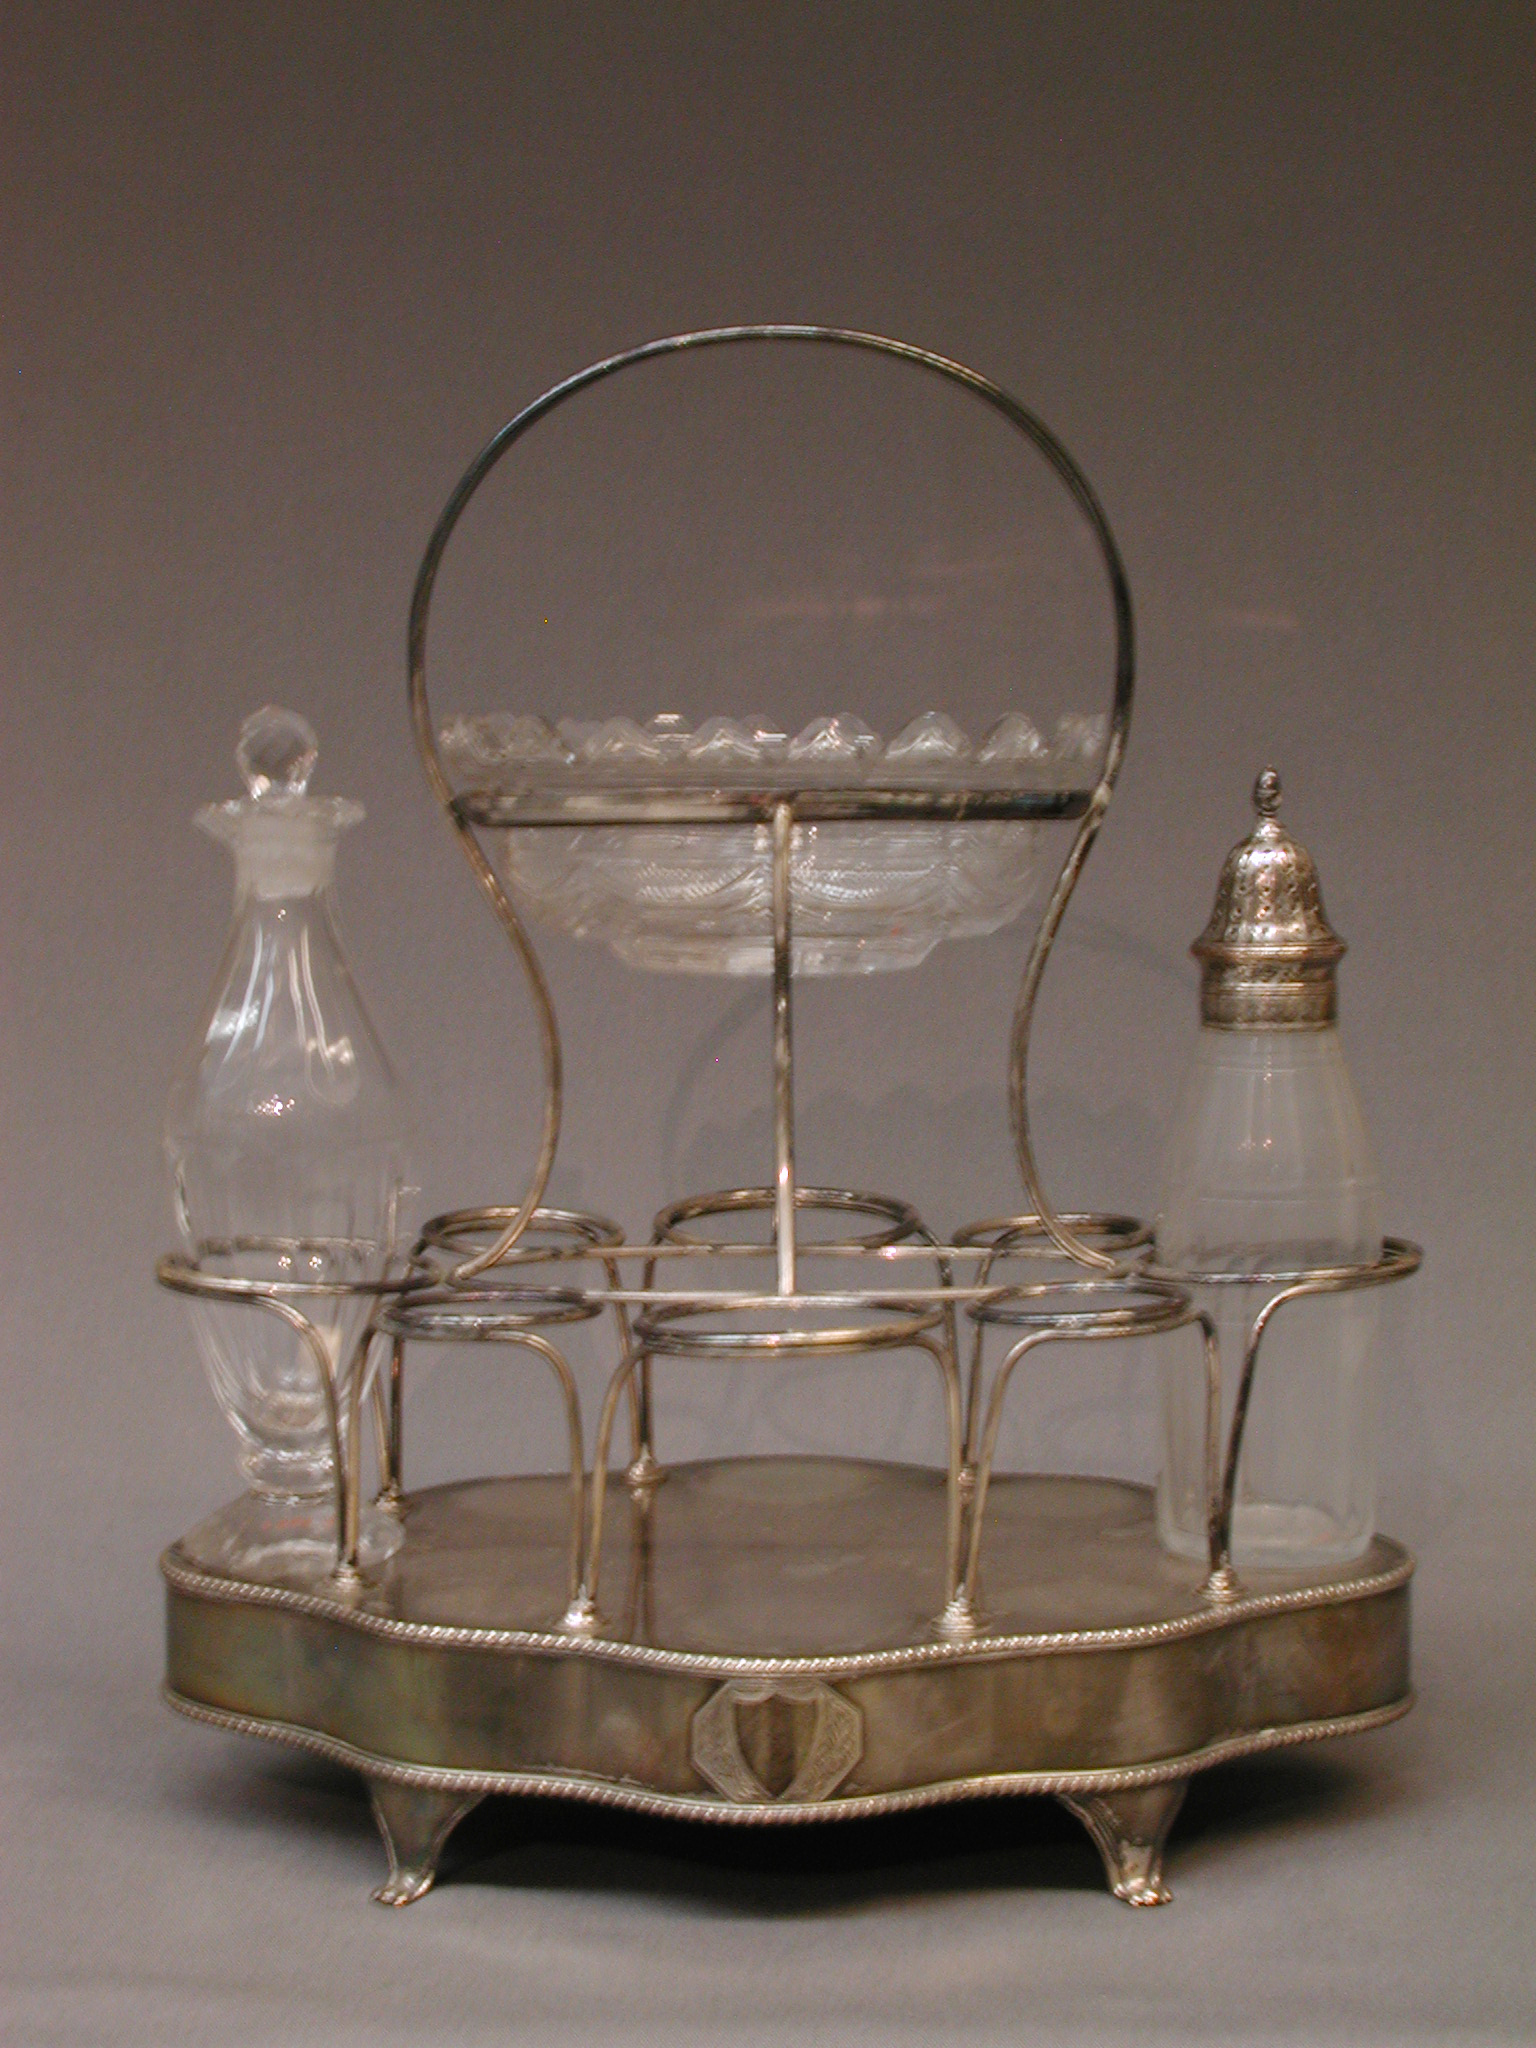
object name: cruet and soy frame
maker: thomas watson and co.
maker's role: maker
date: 1795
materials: glass, metal